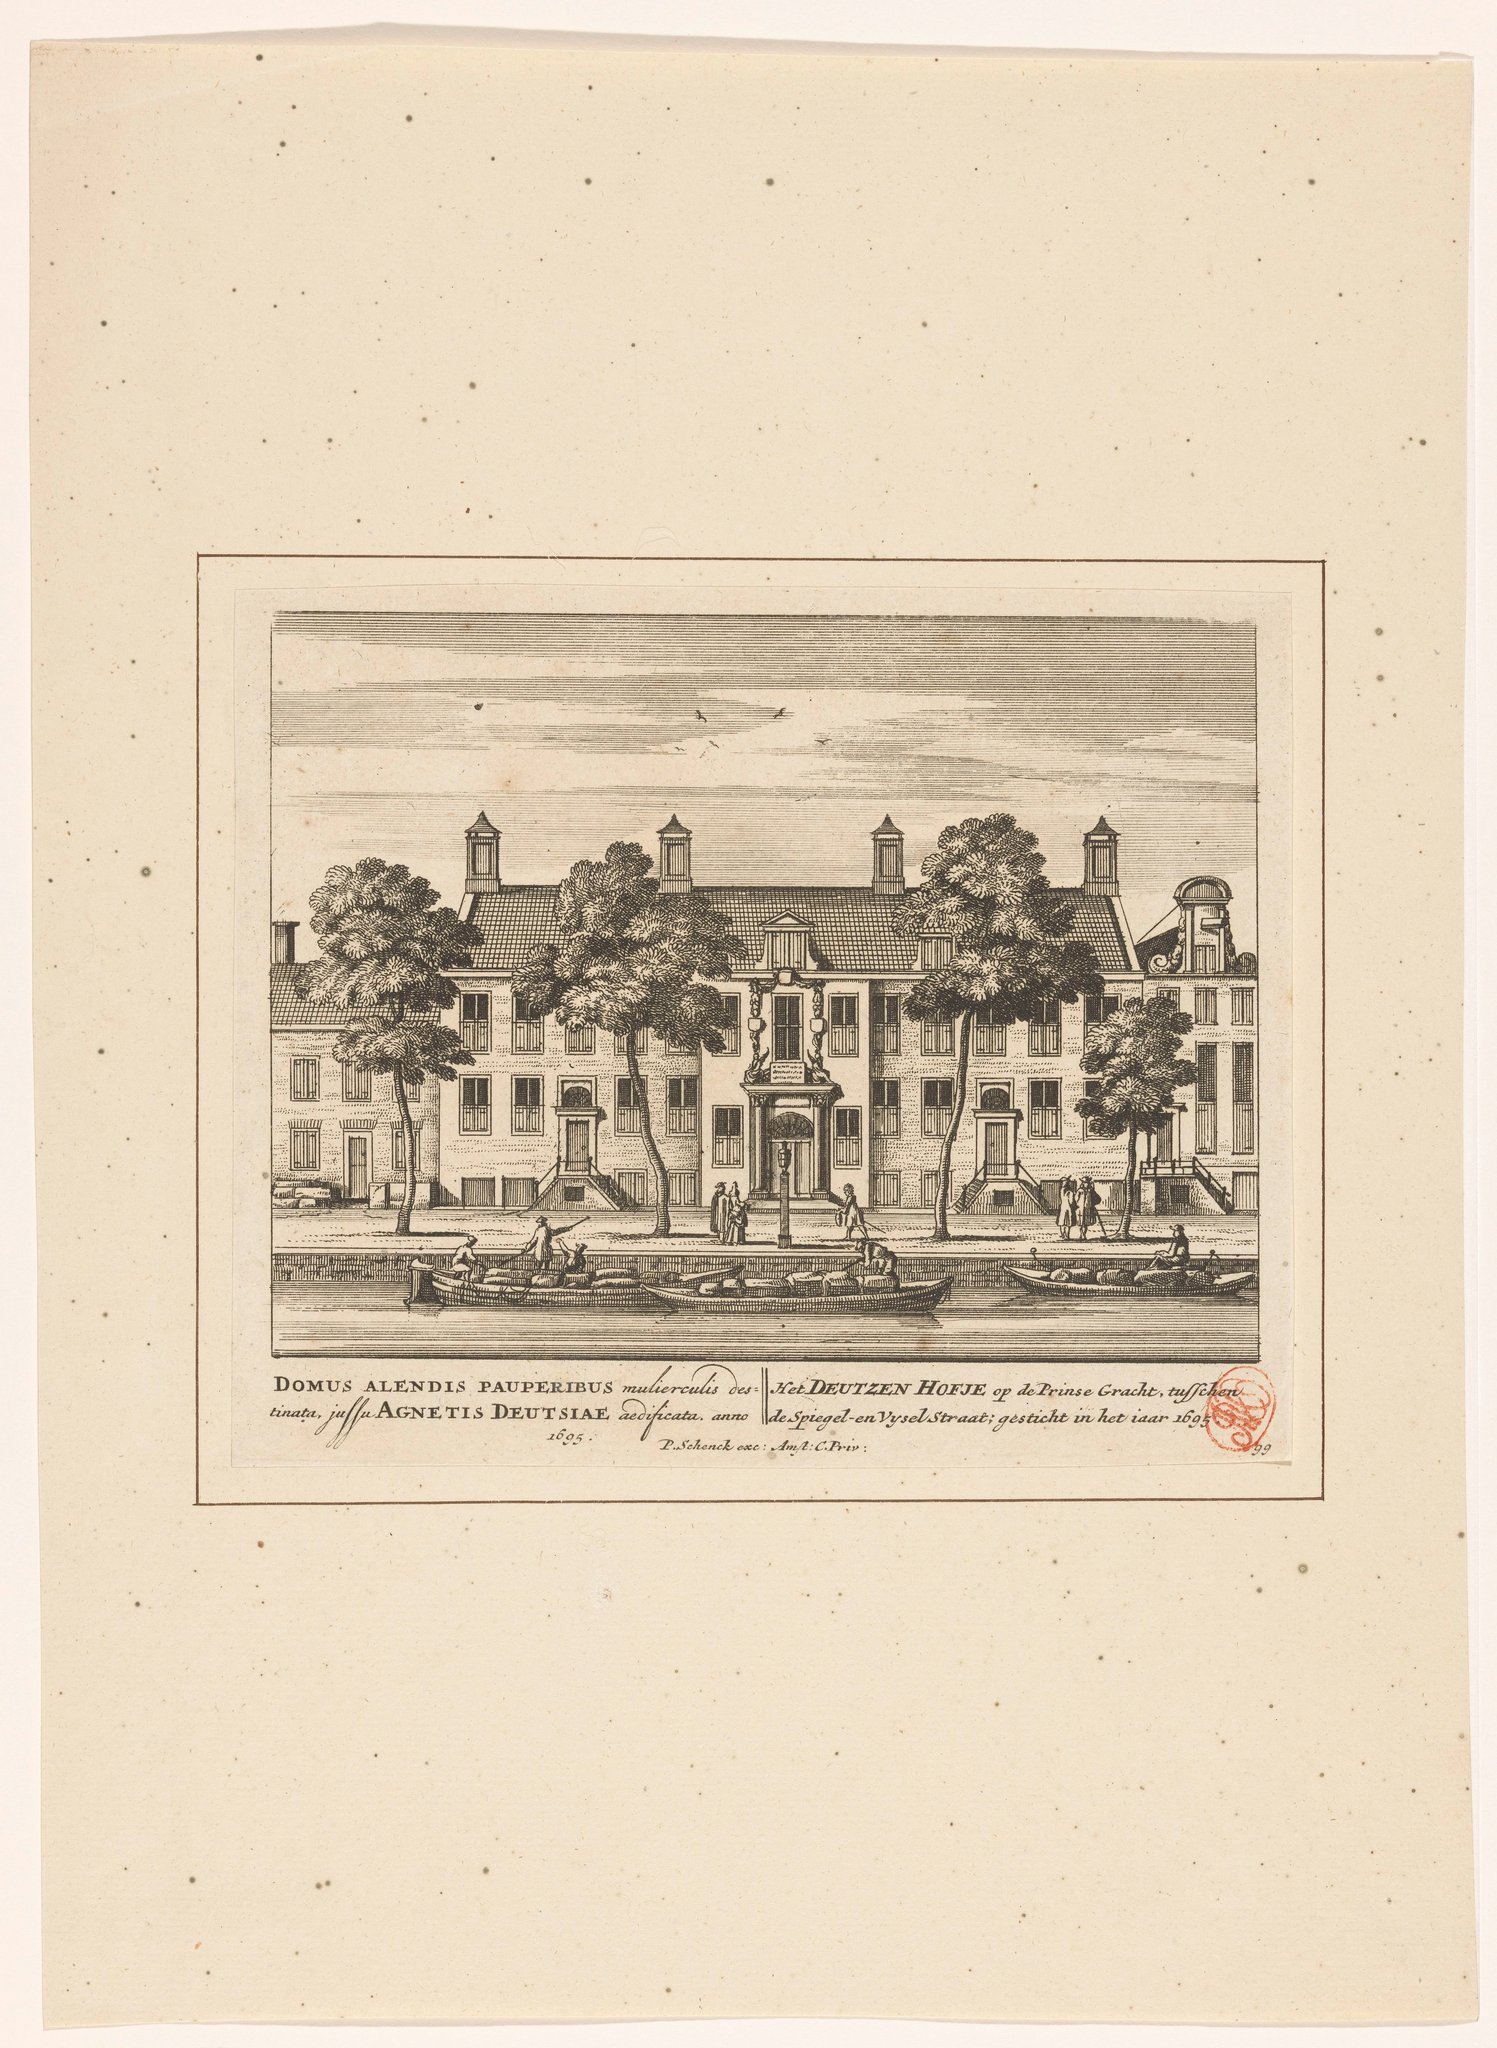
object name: print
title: Domus Alendis Pauperibus mulierculis destinata jussu Agnetis Deutsiae aedificata, anno 1695 / Het Deutzen Hofje op de Prinse Gracht, tusschen de Spiegel- en Vysel Straat; gesticht in het iaar 1695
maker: Anonymous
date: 1710-1711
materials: paper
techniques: engraving, etching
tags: alms-house (dutch: 'hofje'), public welfare, poorhouse, canals, waters (in city) (+ city(-scape) with figures, staffage), street (+ city(-scape) with figures, staffage)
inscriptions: collector's mark: Lugt 195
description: Huidige staat van prent ook gebruikt in: 100 Afbeeldinge der voornaamste gebouwen van Amsterdam. Amsterdam, Pieter Schenk (I), s.a. [1710-1711]. En in: 100 Afbeeldinge der voornaamste gebouwen van Amsterdam. Amsterdam, Barent Greve, s.a. [1757-1766].* *In de tweede uitgave, uitgegeven door Barent Greve, is alleen de titelprent aangepast. De overige prenten zijn onveranderd gebleven.